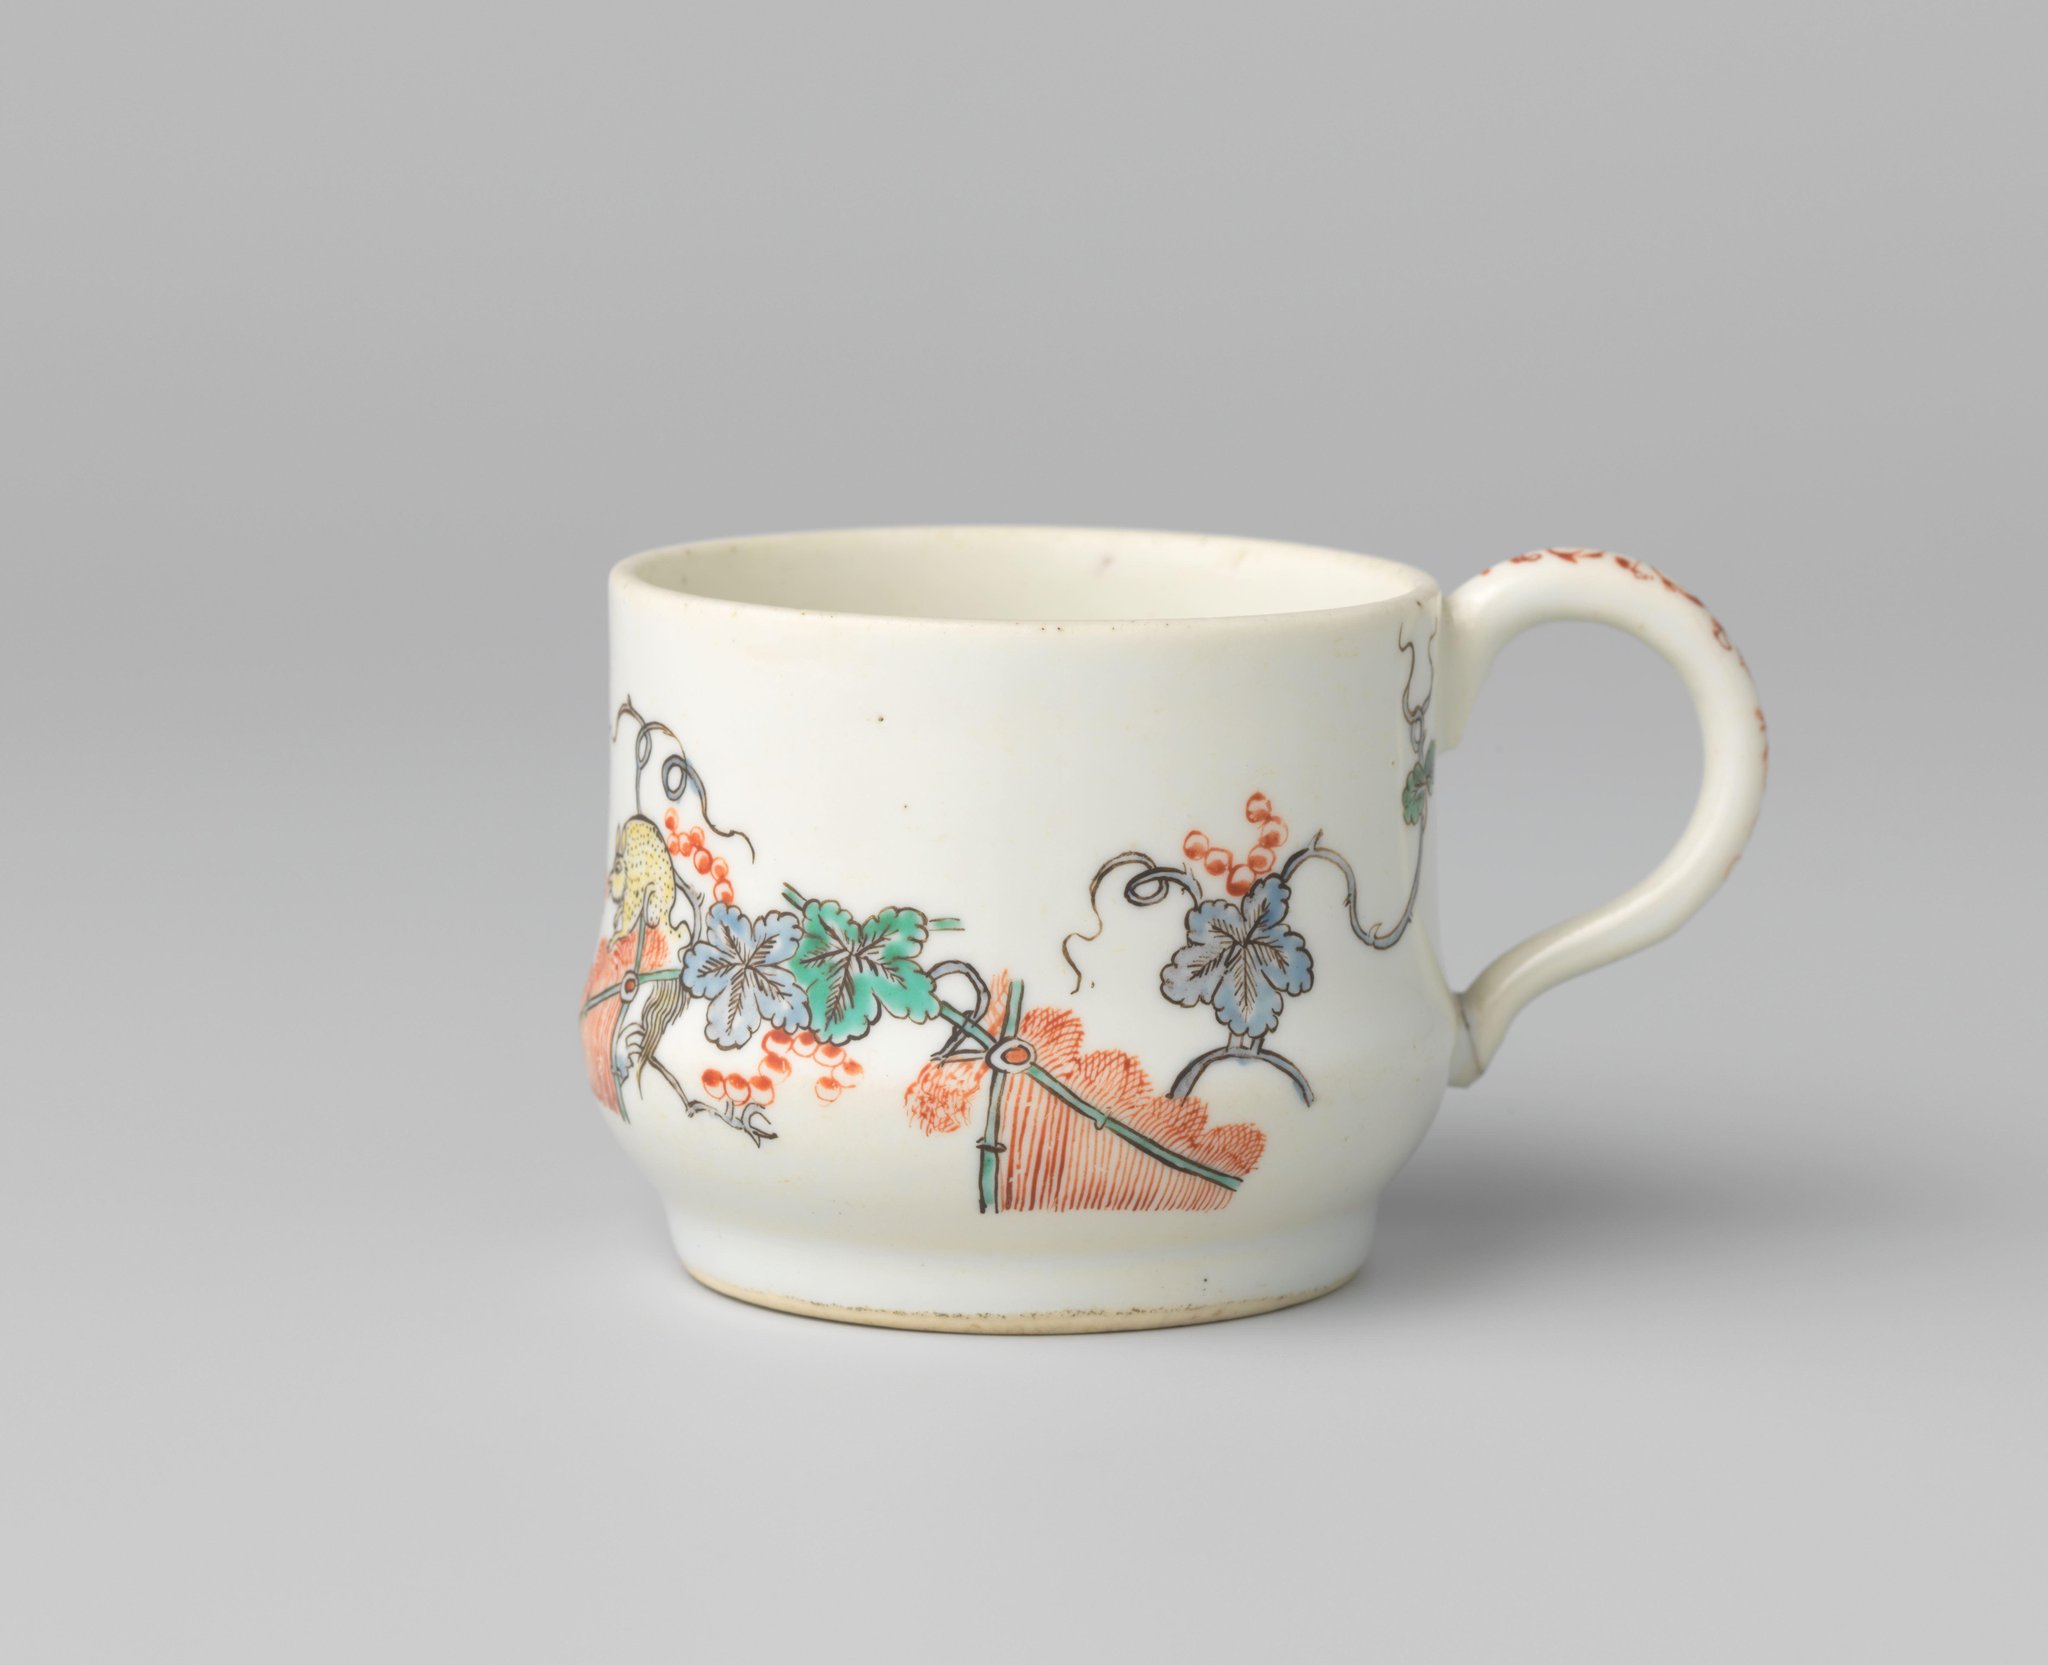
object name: cup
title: Cup with a squirrel on grapevines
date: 1740-1750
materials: glaze, paint, porcelain, soft paste porcelain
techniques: firing, forming, turning, vitrification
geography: mennecy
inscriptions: mark: ‘D.V.’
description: Cup, soft paste porcelain Mennecy, c. 1740 - 1750